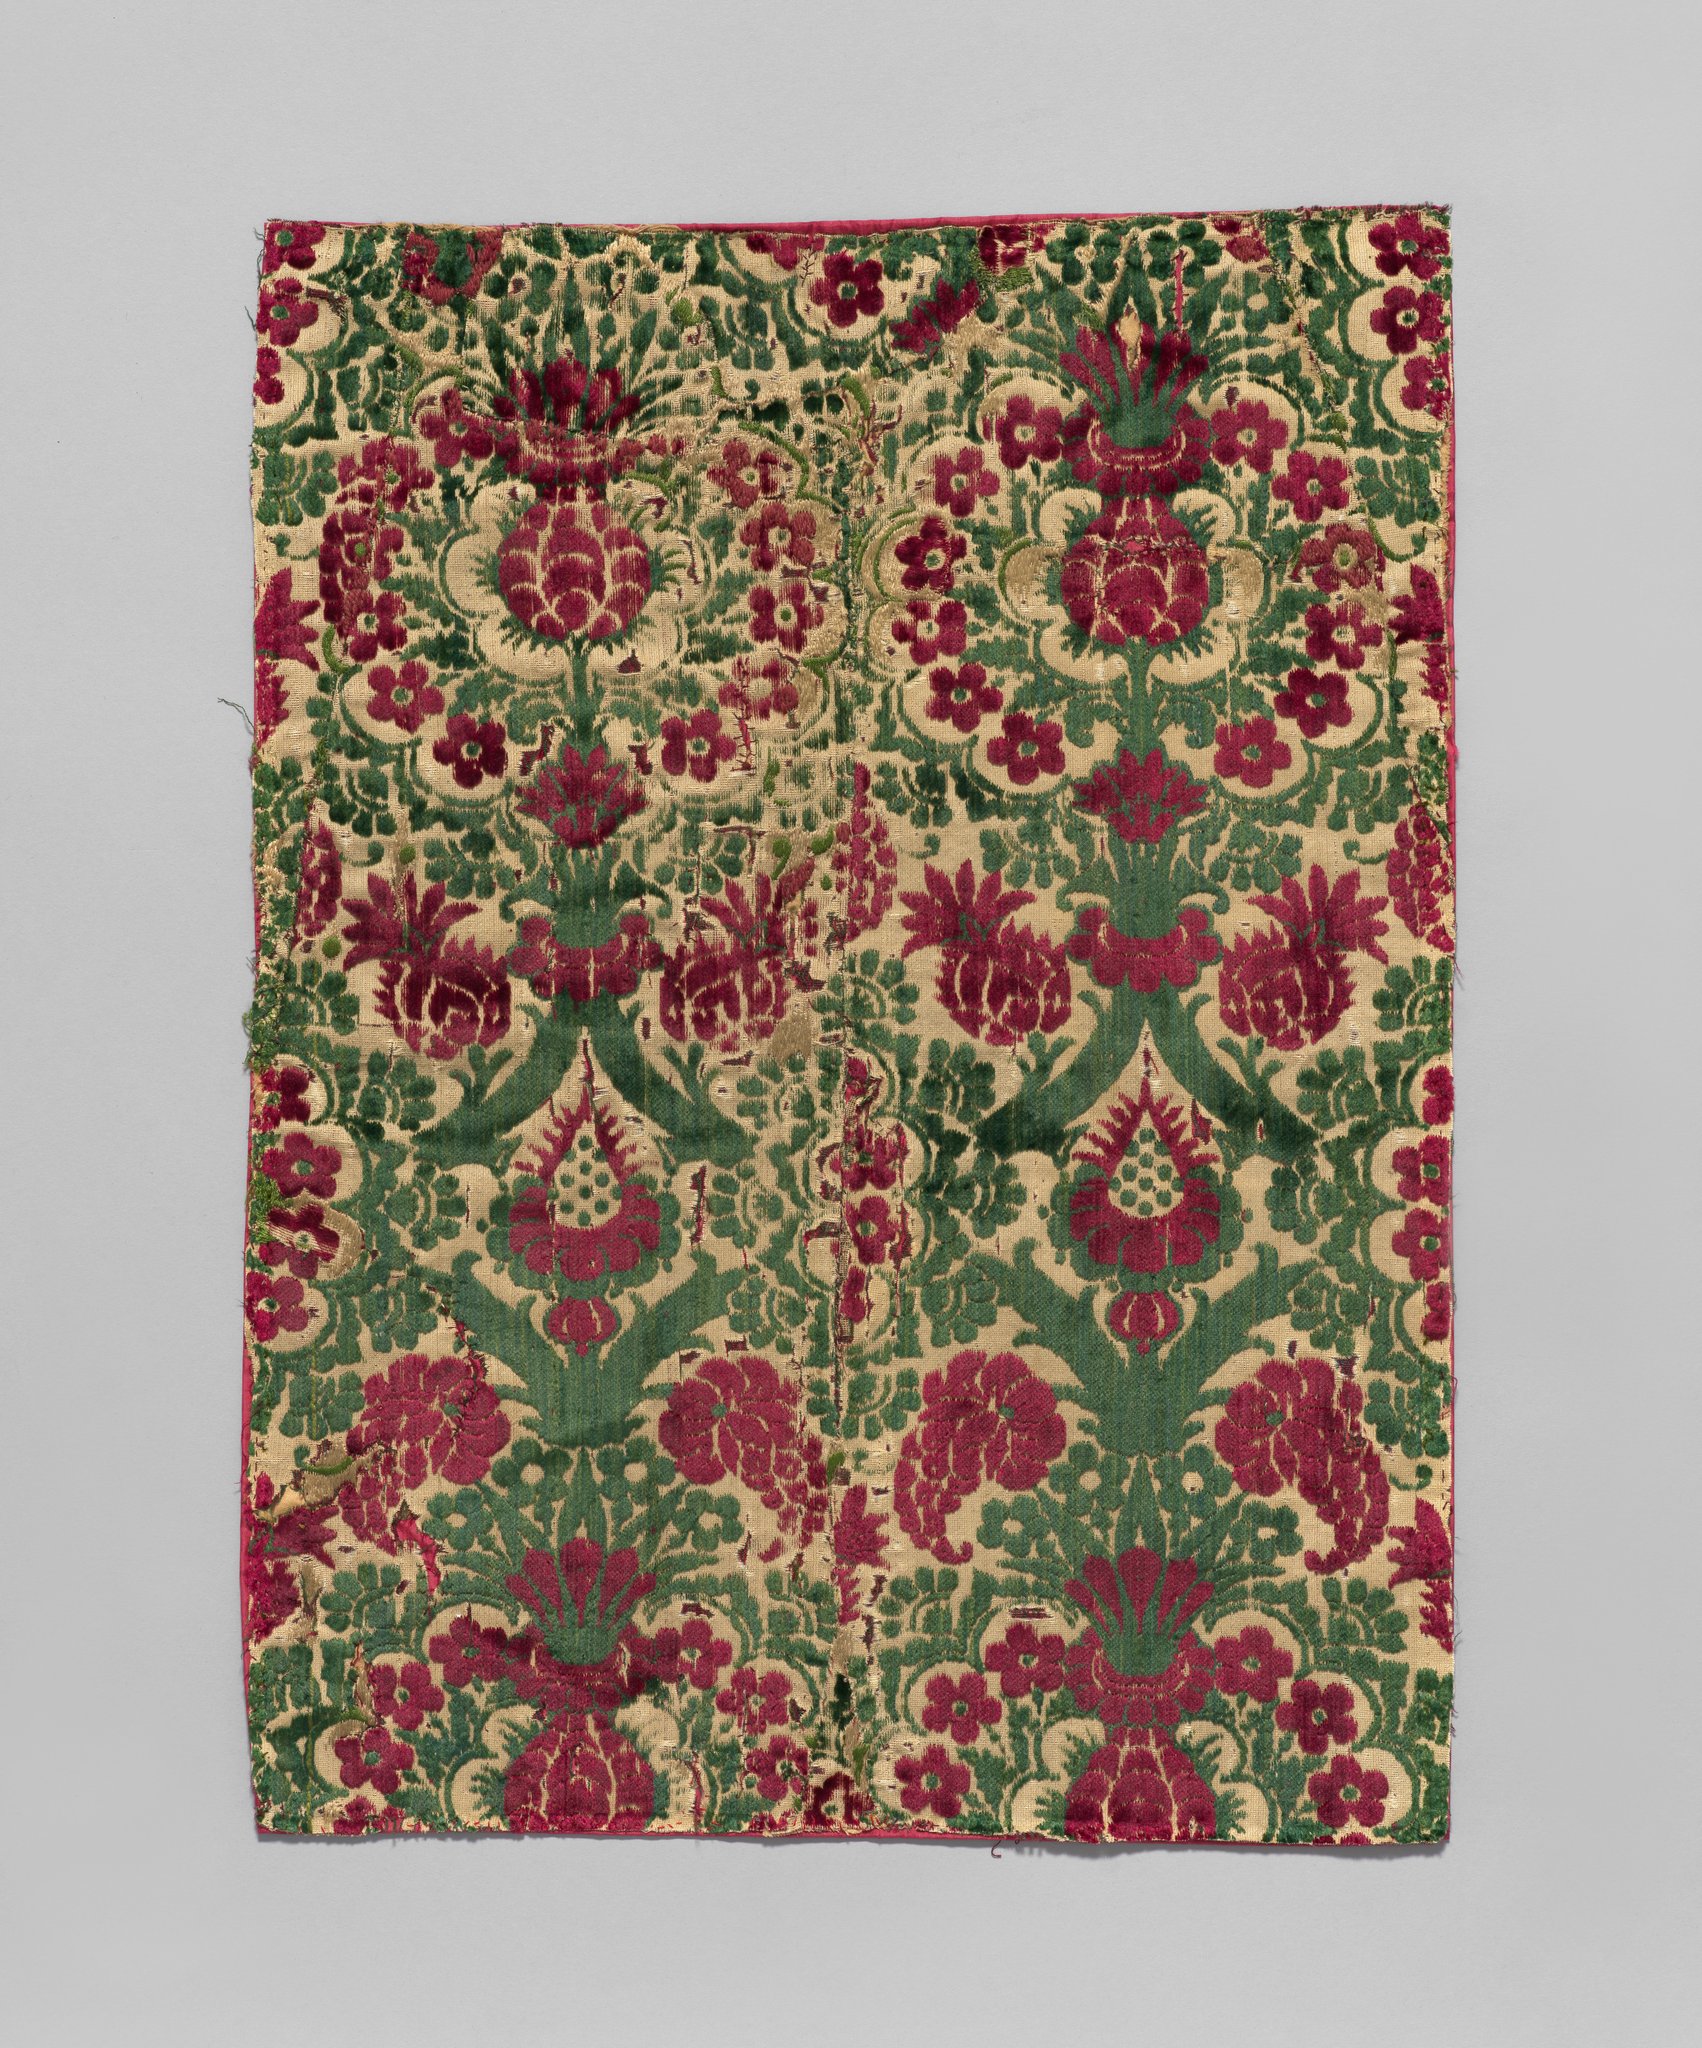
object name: piece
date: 1467-1500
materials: silk